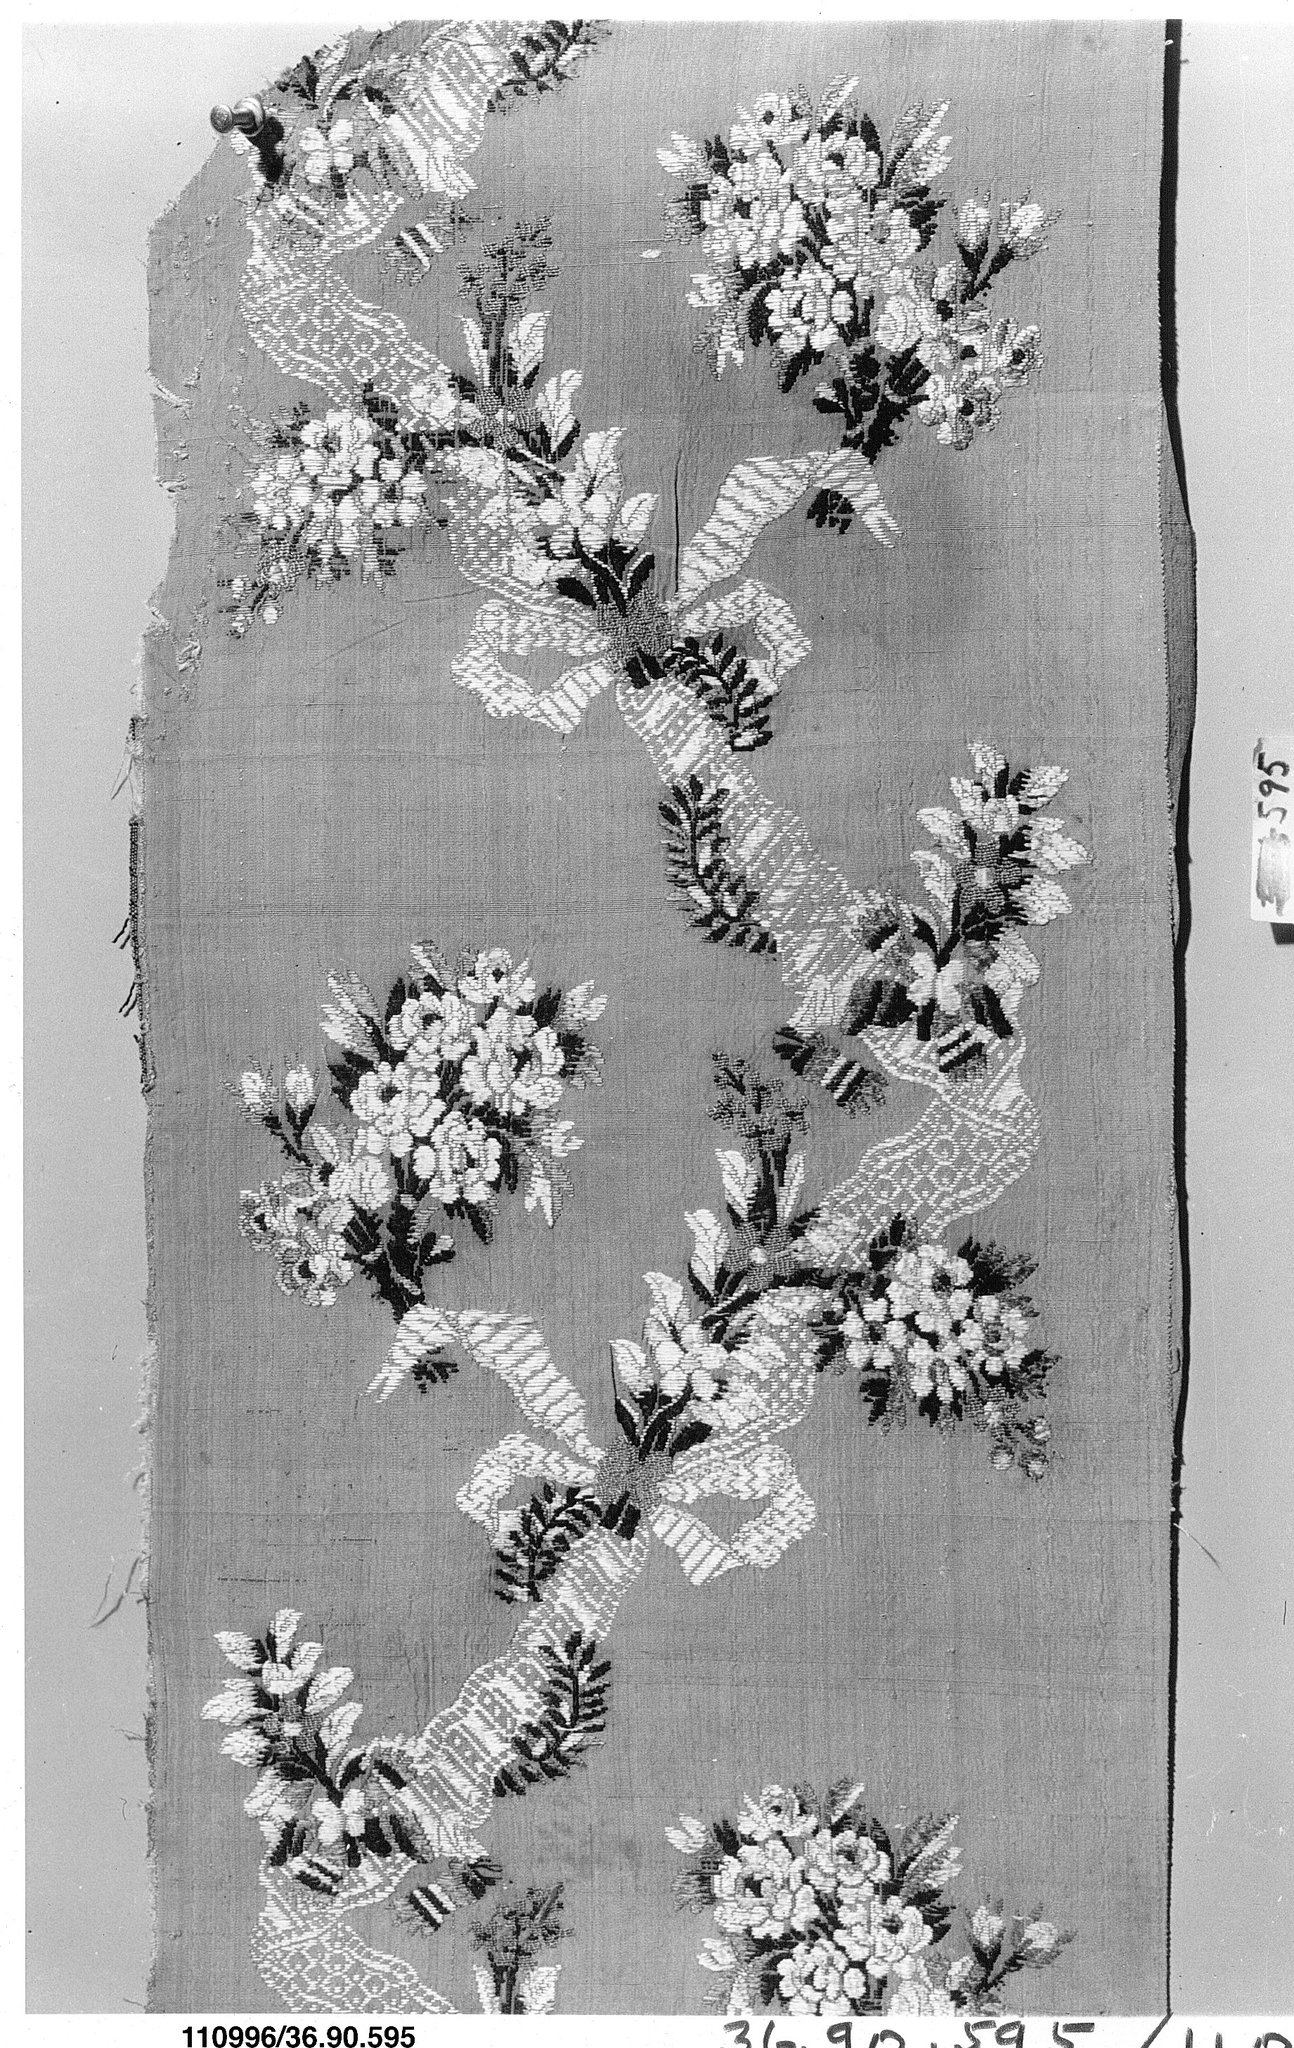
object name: piece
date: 1734-1766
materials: silk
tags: flowers,leaves